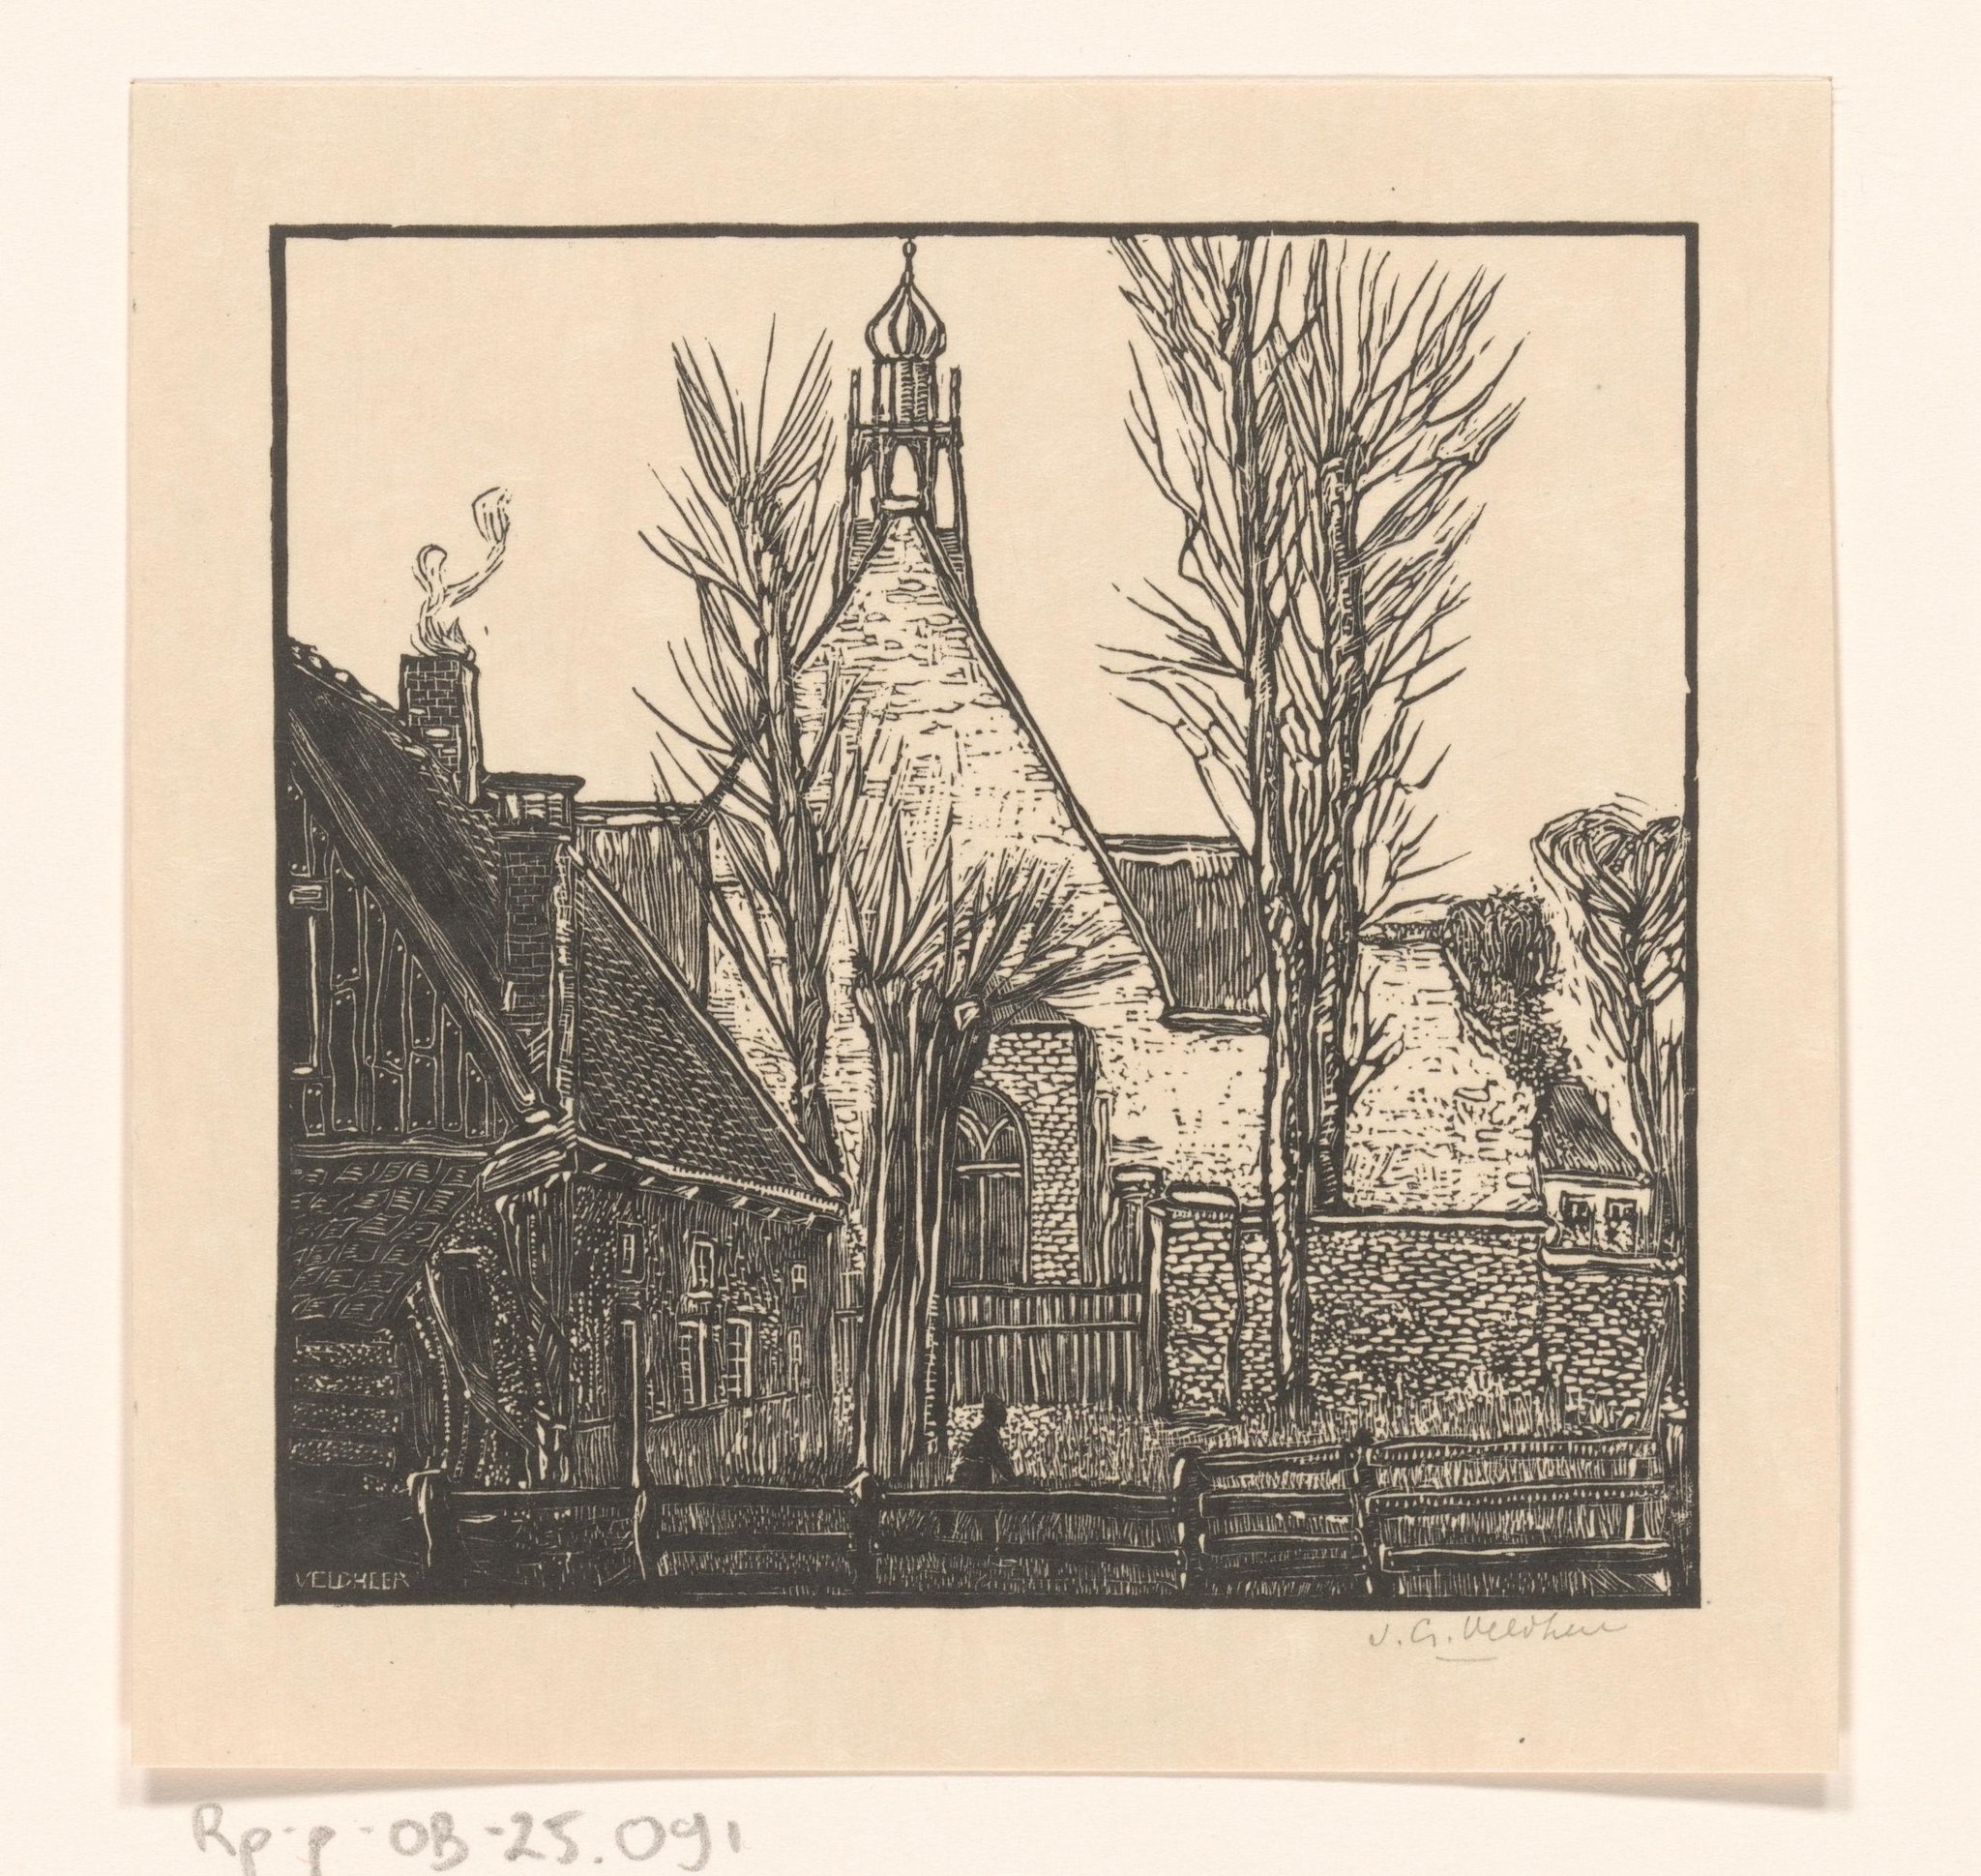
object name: print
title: De kerk te Bergen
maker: jacobus gerardus veldheer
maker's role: draughtsman, print maker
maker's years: 1866-1954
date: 1876-1954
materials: paper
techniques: woodcut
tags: church (exterior)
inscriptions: collector's mark: Lugt 2228